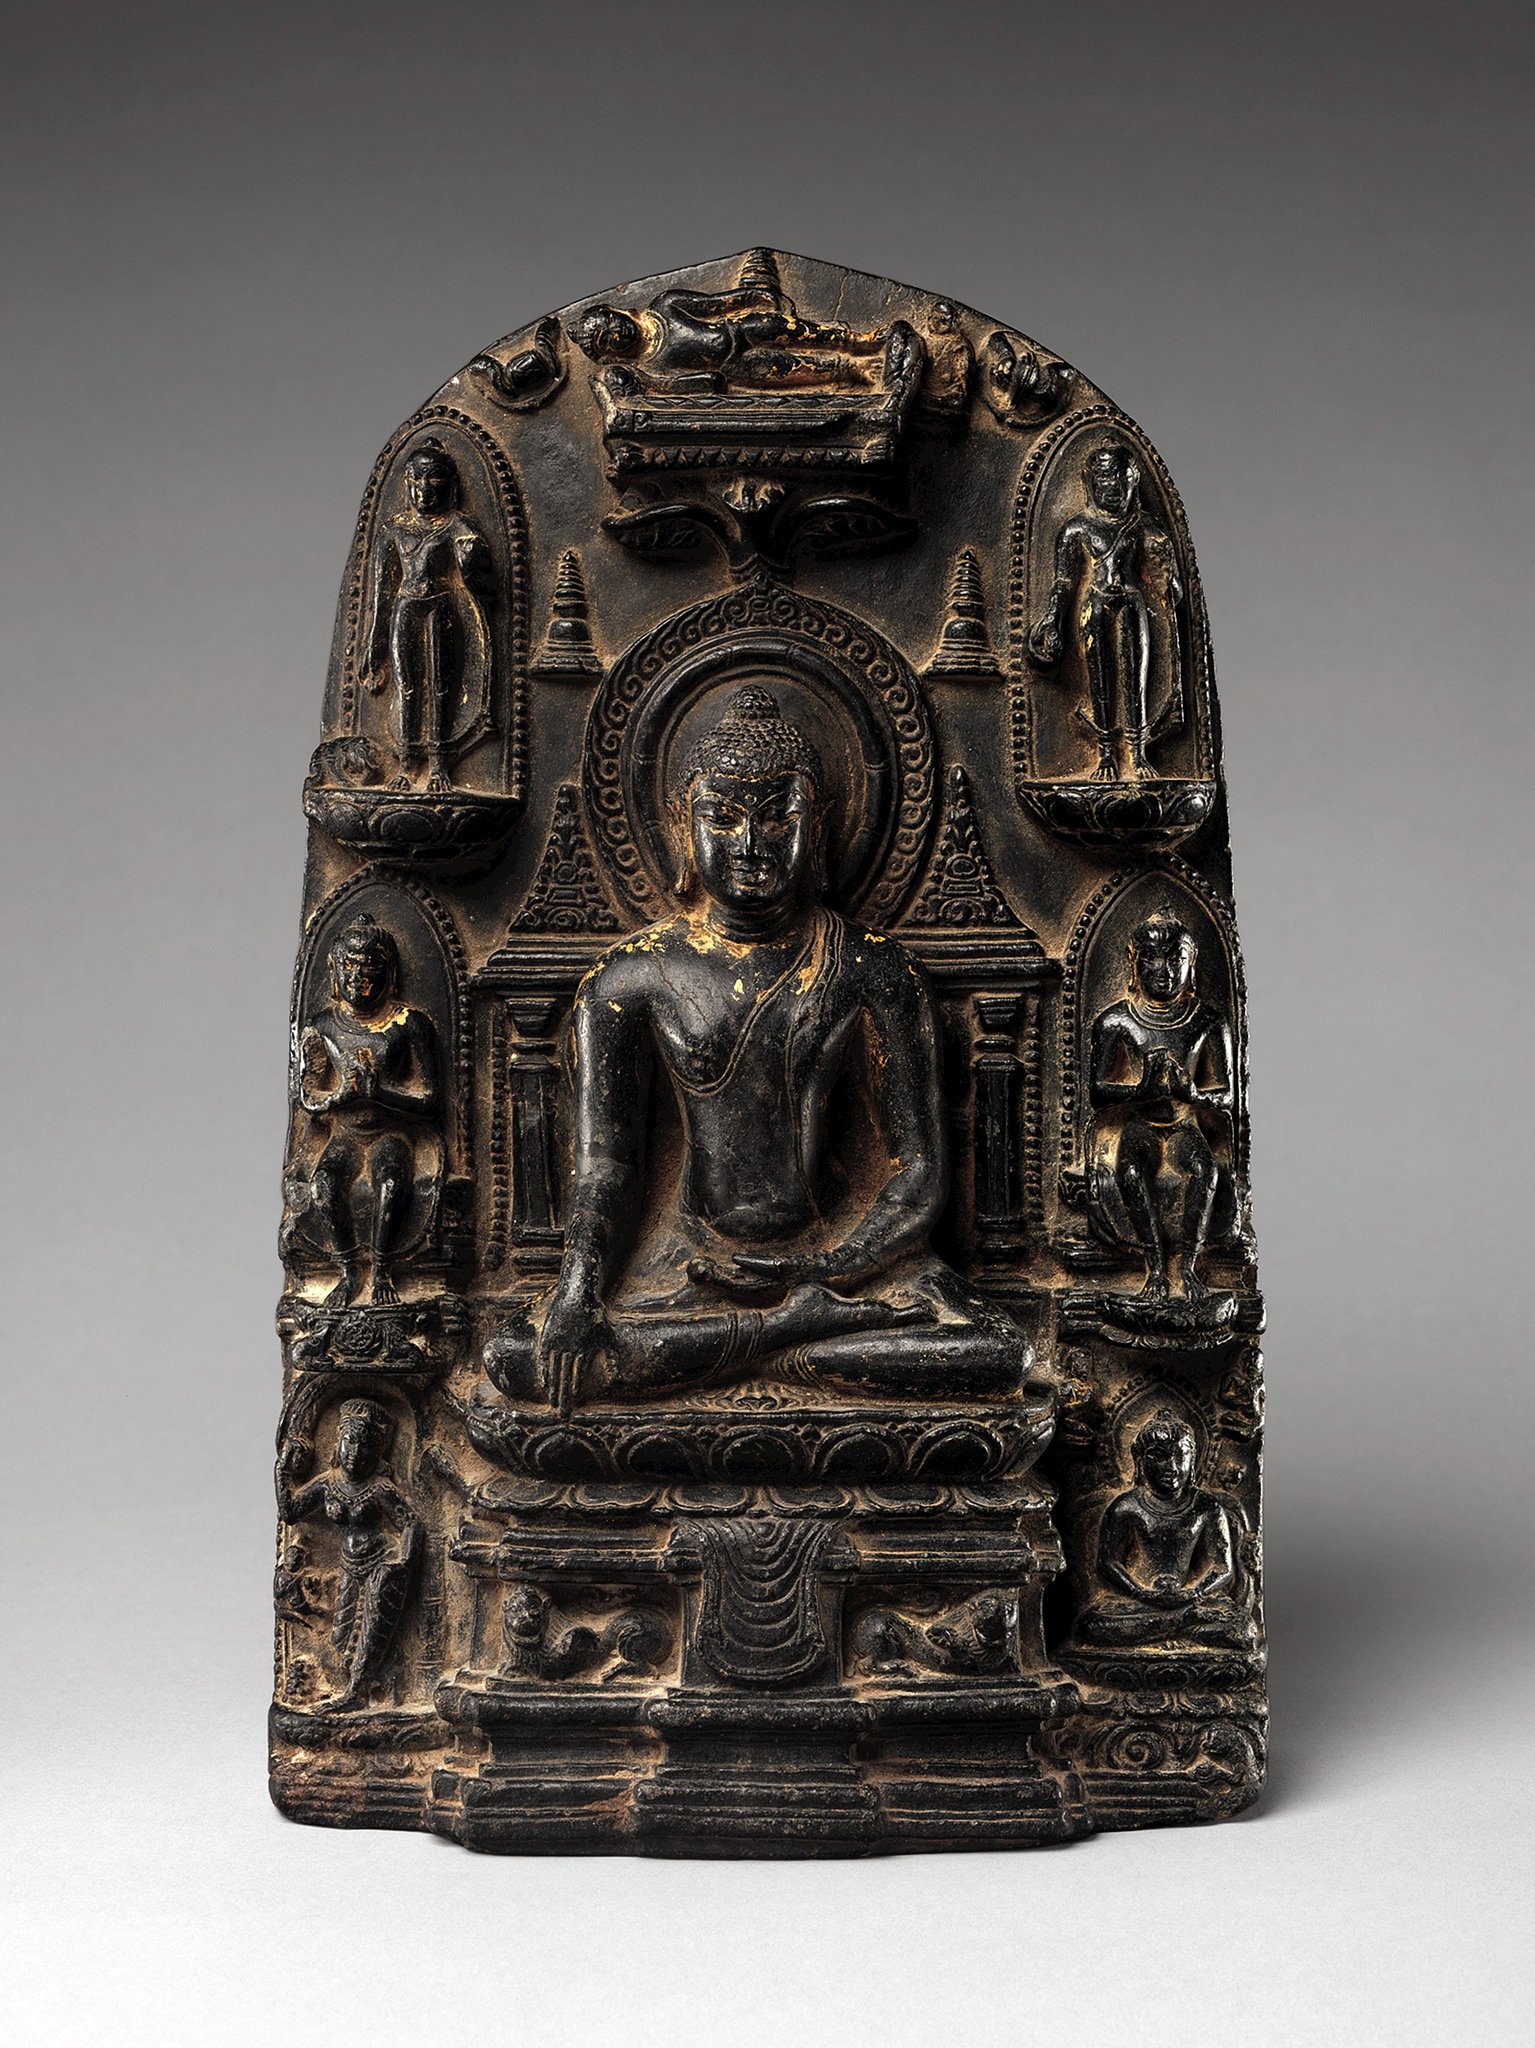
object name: stele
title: Stele with Eight Great Events from the Life of the Buddha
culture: indian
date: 901-1000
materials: stone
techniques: gilding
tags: buddhism,buddha